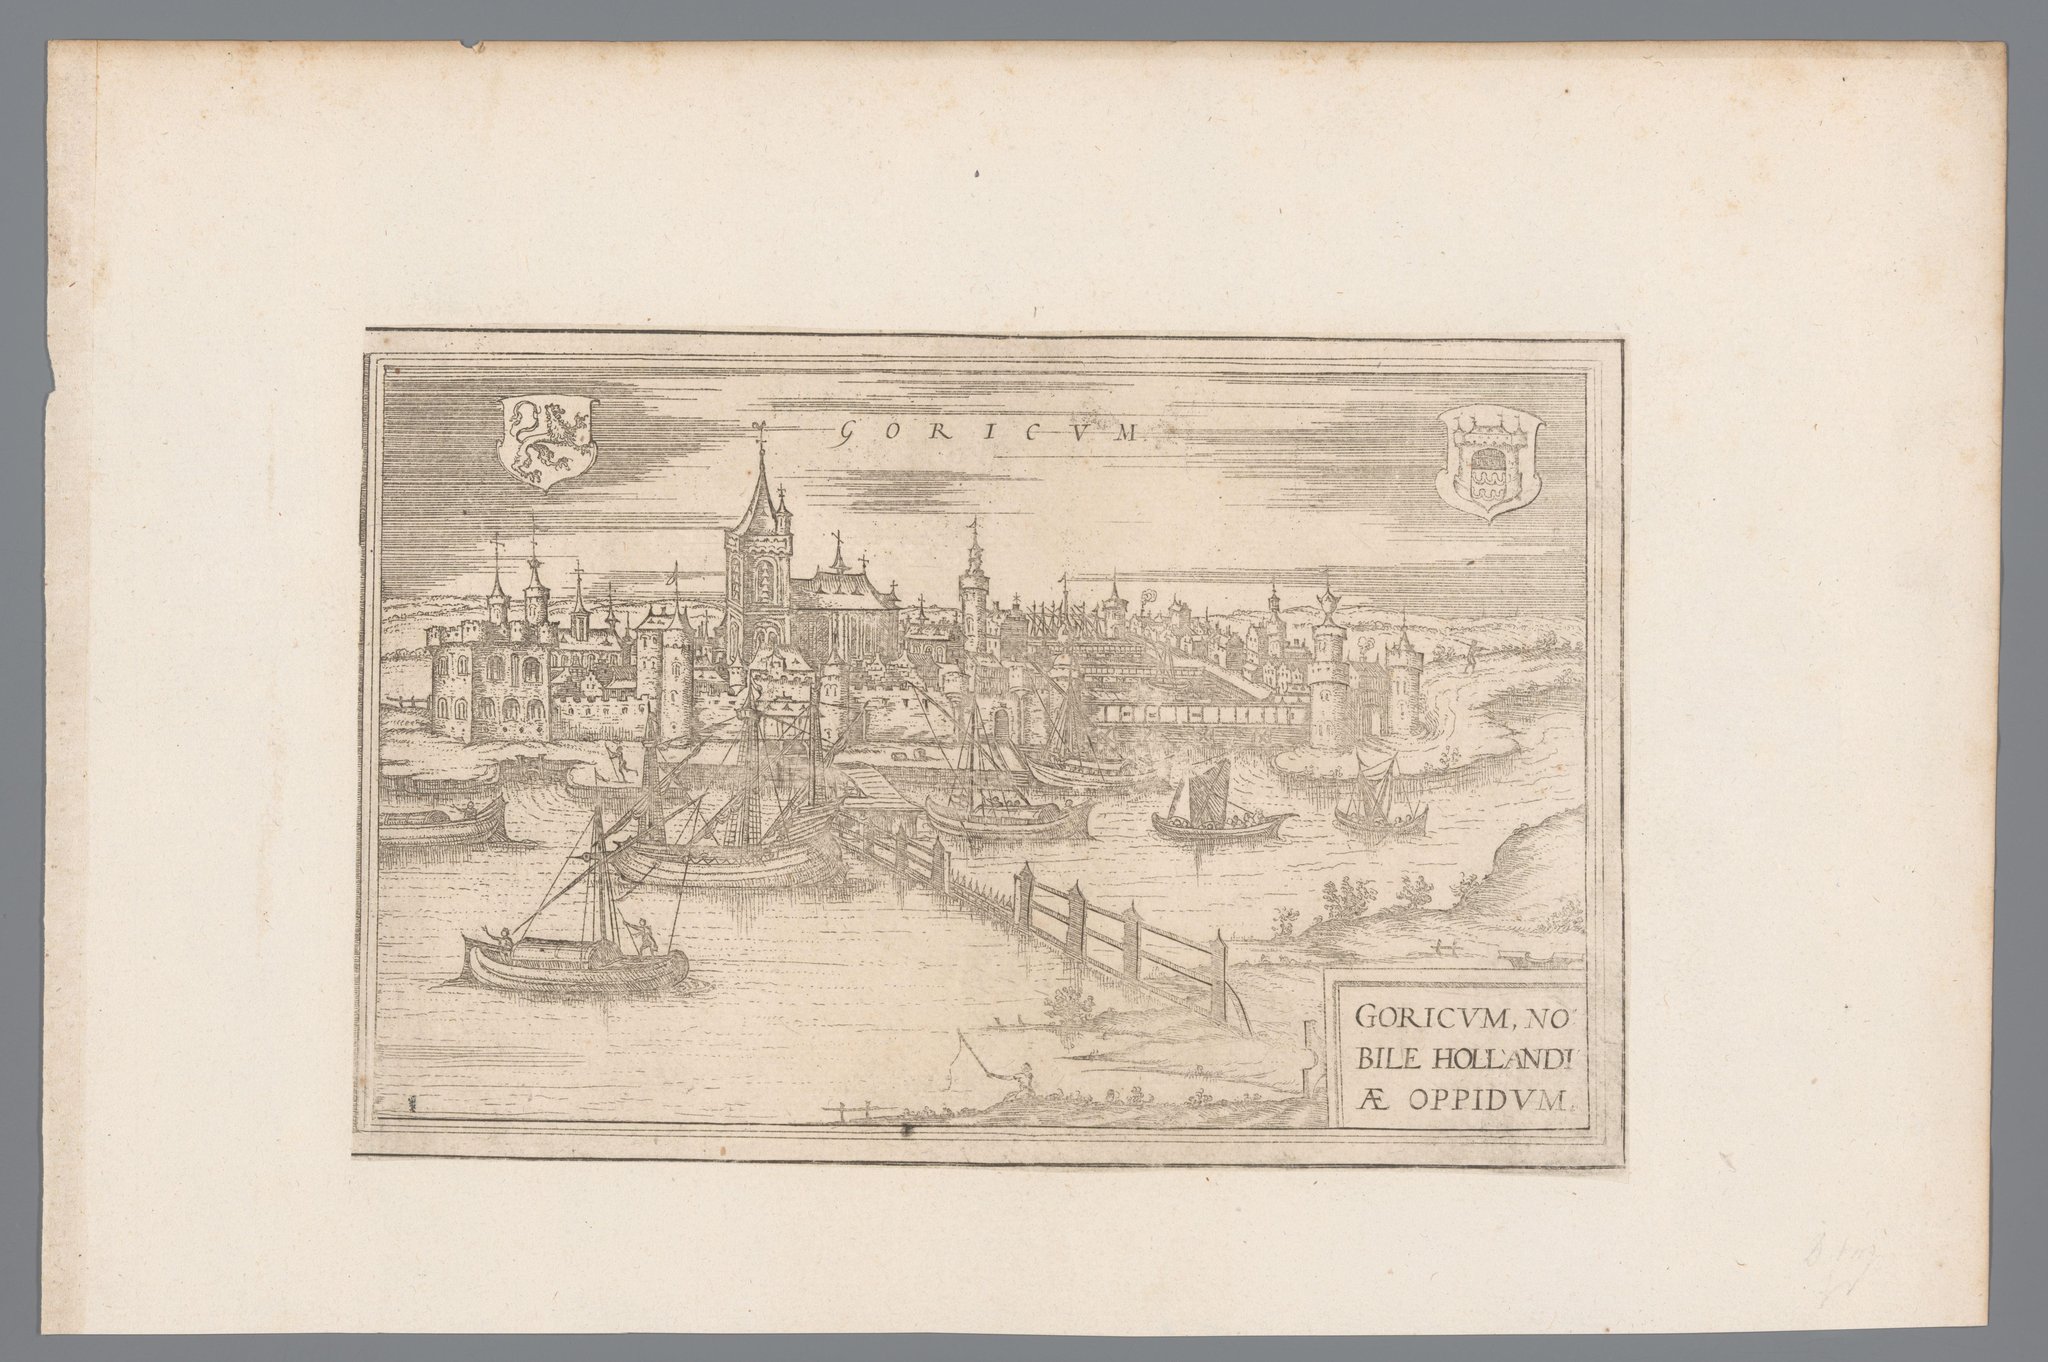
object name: print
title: Gezicht op Gorinchem vanaf de Merwede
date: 1572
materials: paper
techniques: engraving, etching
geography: cologne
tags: city-view, and landscape with man-made constructions, harbour (+ number of persons ~ traffic and transport)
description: Prent uit: Braun, Georg en Frans Hogenberg. Civitates orbis terrarum. Keulen: Theodorus Graminaeus, 1572, dl. 1.